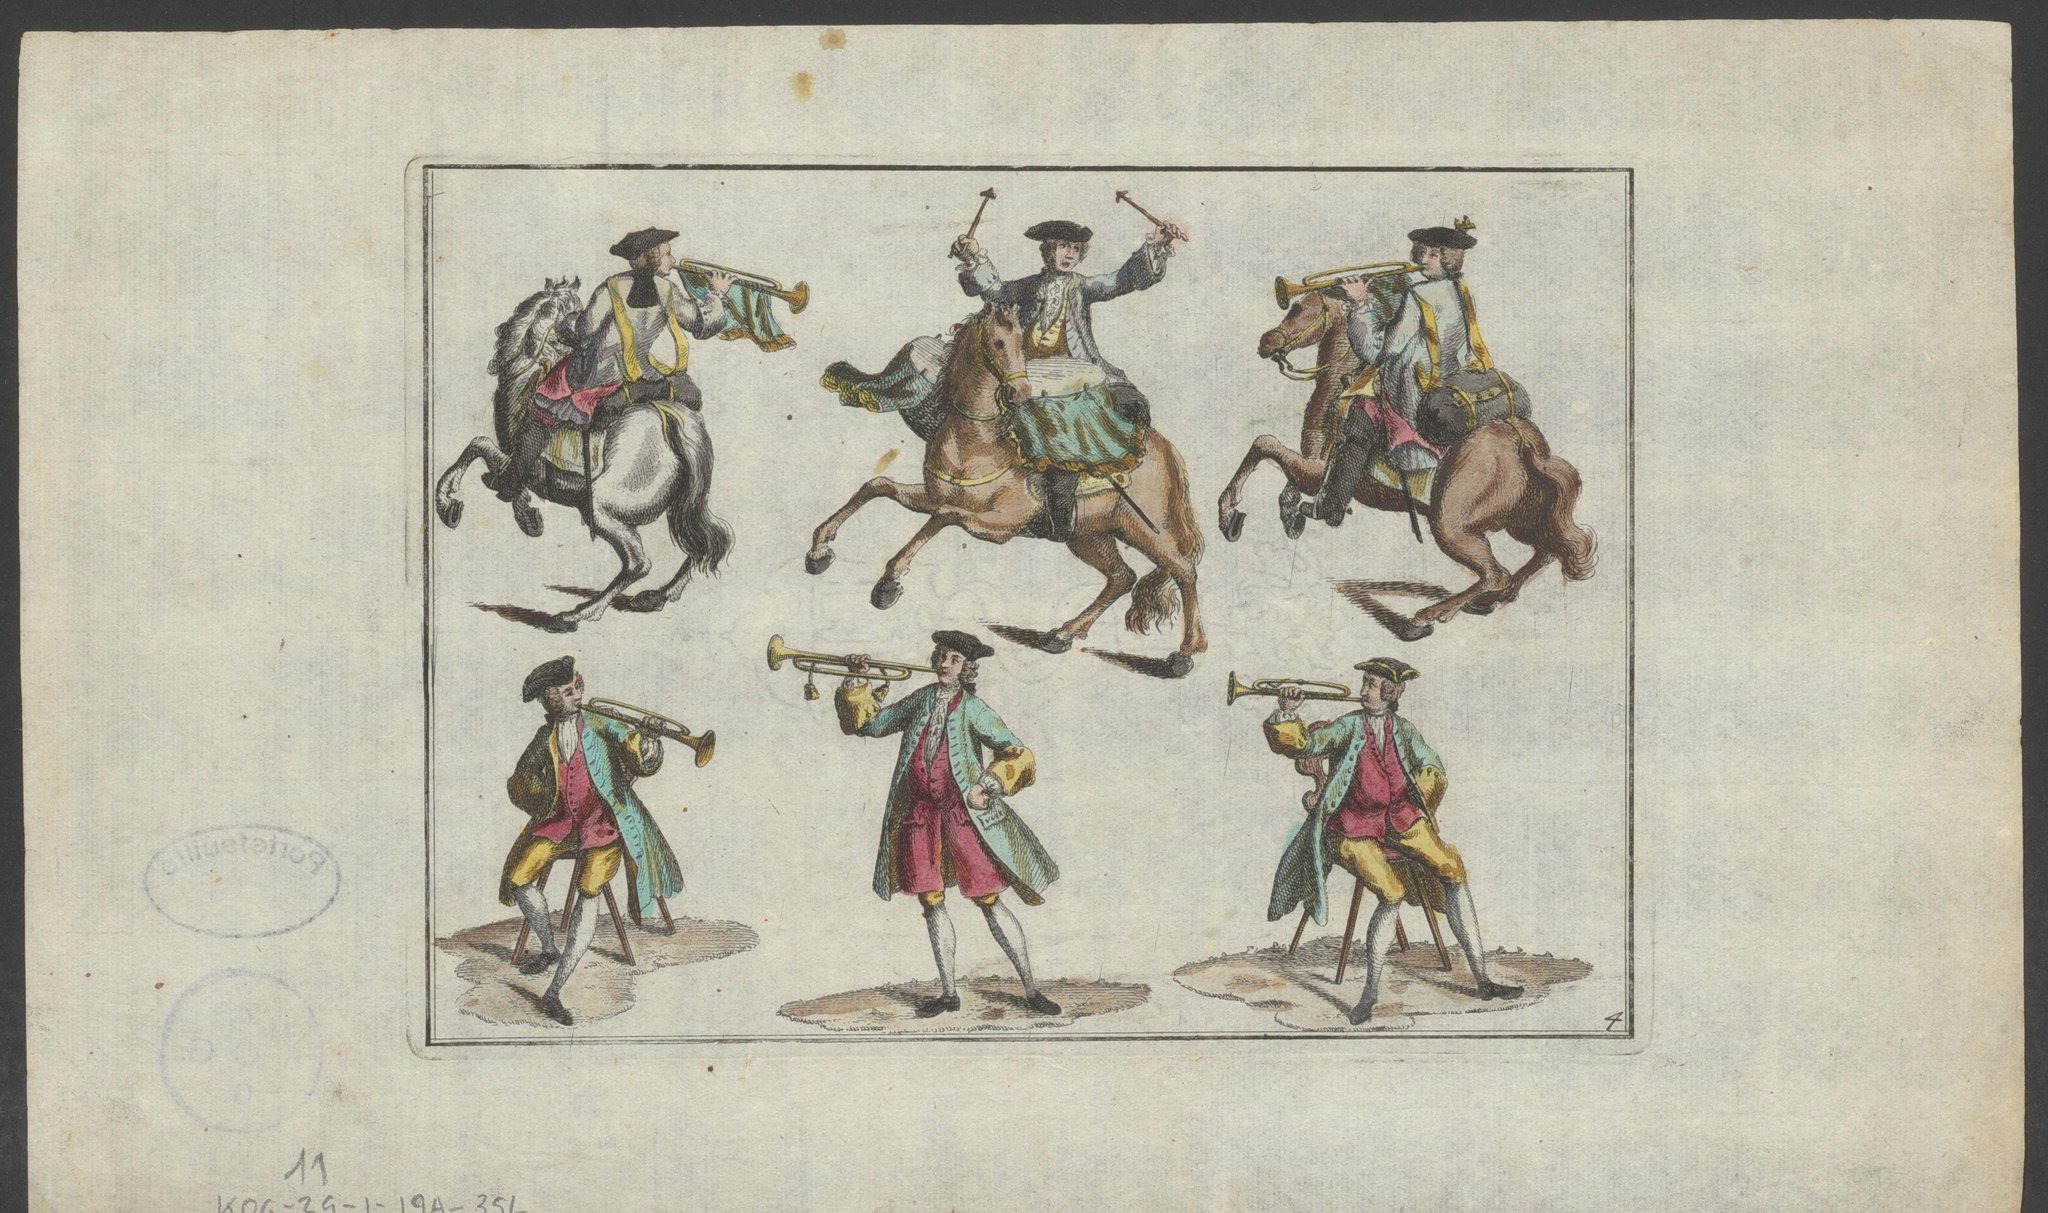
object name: print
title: Muzikanten met en zonder paard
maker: Anonymous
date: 1800-1899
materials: paper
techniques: engraving, etching, hand coloring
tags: musician at work, horn, trumpet, cornet, trombone, tuba, the soldier; the soldier's life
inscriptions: collector's mark: Lugt 1641, stamp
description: Zes voorstellingen van muzikanten. De bovenste drie te paard, de middelste slaat op de trommel en de ruiters links en rechts blazen op een trompet. Onderaan drie trompettisten de middelste staat en aan de zijkant zitten zij op een kruk. Onderwerpsrubrieken binnen de Atlas Zeden en Gewoonten: Zeden en Gewoonten in Engeren Zin, Des menschen beging, midden en einde, Kinderleven – Kinderspel en Kinderprenten.